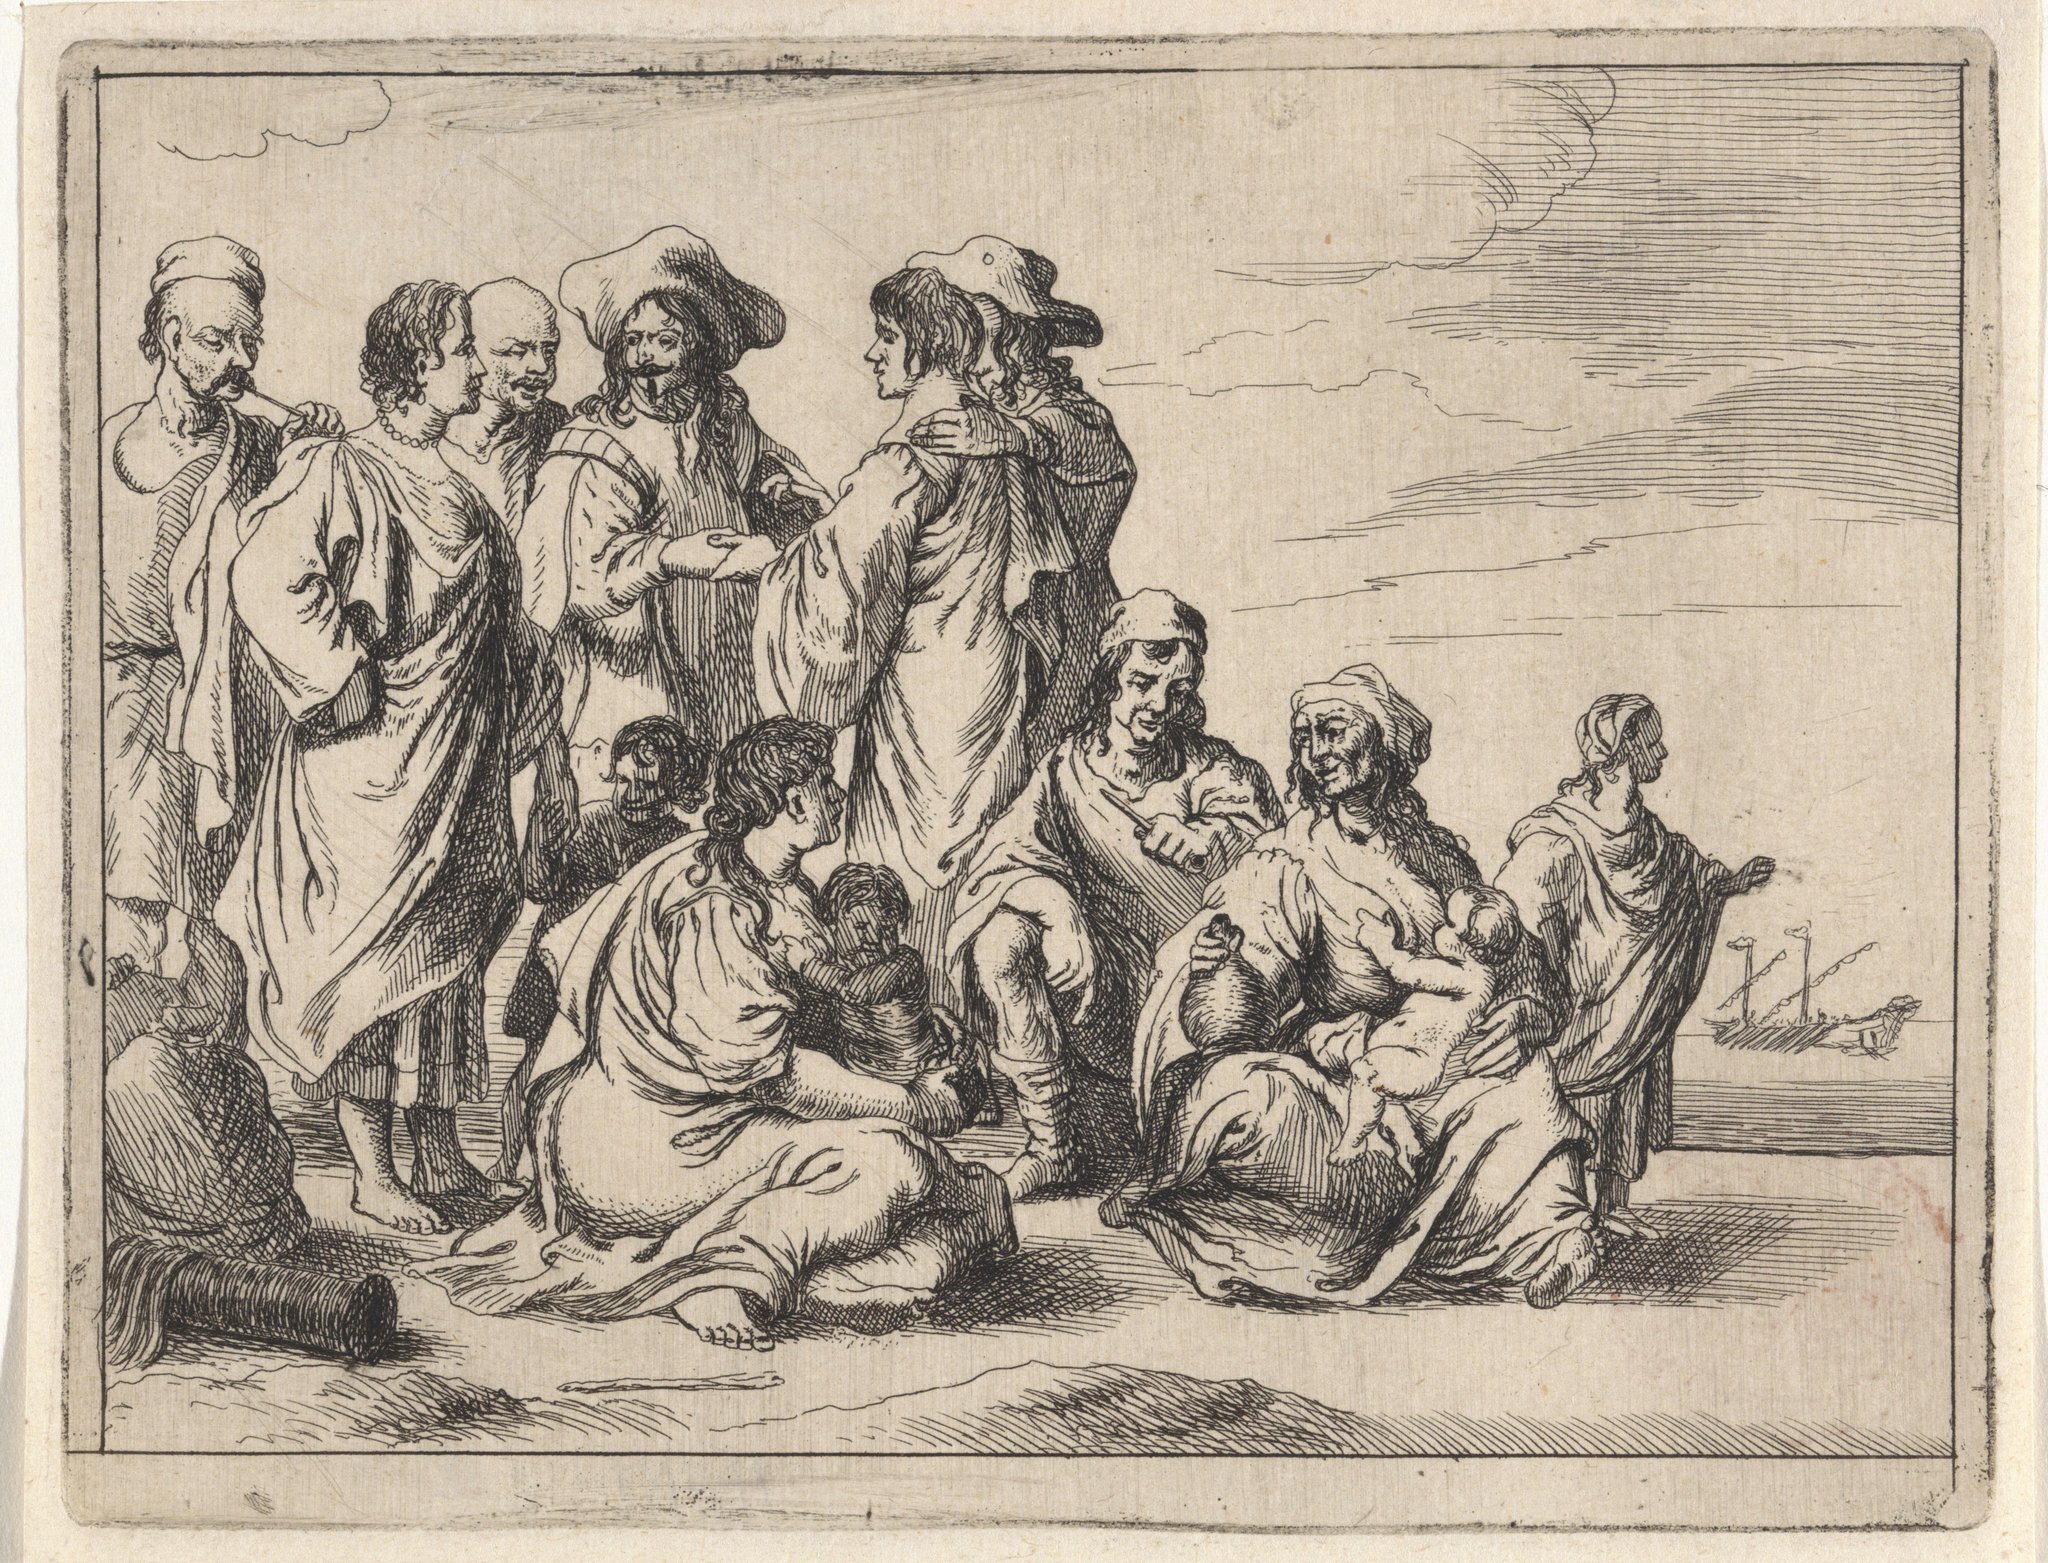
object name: print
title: Haventaferelen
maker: m. schaep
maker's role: print maker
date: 1649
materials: paper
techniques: etching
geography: genoa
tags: harbour, family group, especially parents with their child(ren), seaman: sailor, beach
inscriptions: collector's mark: Lugt 240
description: Een man zit geknield naast twee vrouwen met hun kinderen. Achter hen twee mannen (waarschijnlijk soldaten) in gesprek met twee vrouwen. Daarachter kijken twee islamitische galeislaven toe. Deze tot slaaf gemaakte mannen zijn als moslims te herkennen door het typerende kapsel (hoofd op een pluk na kaalgeschoren) dat zij verplicht waren te hebben. Linksvoor staan twee zakken bij een kanon. Rechts in de verte vaart een galei.